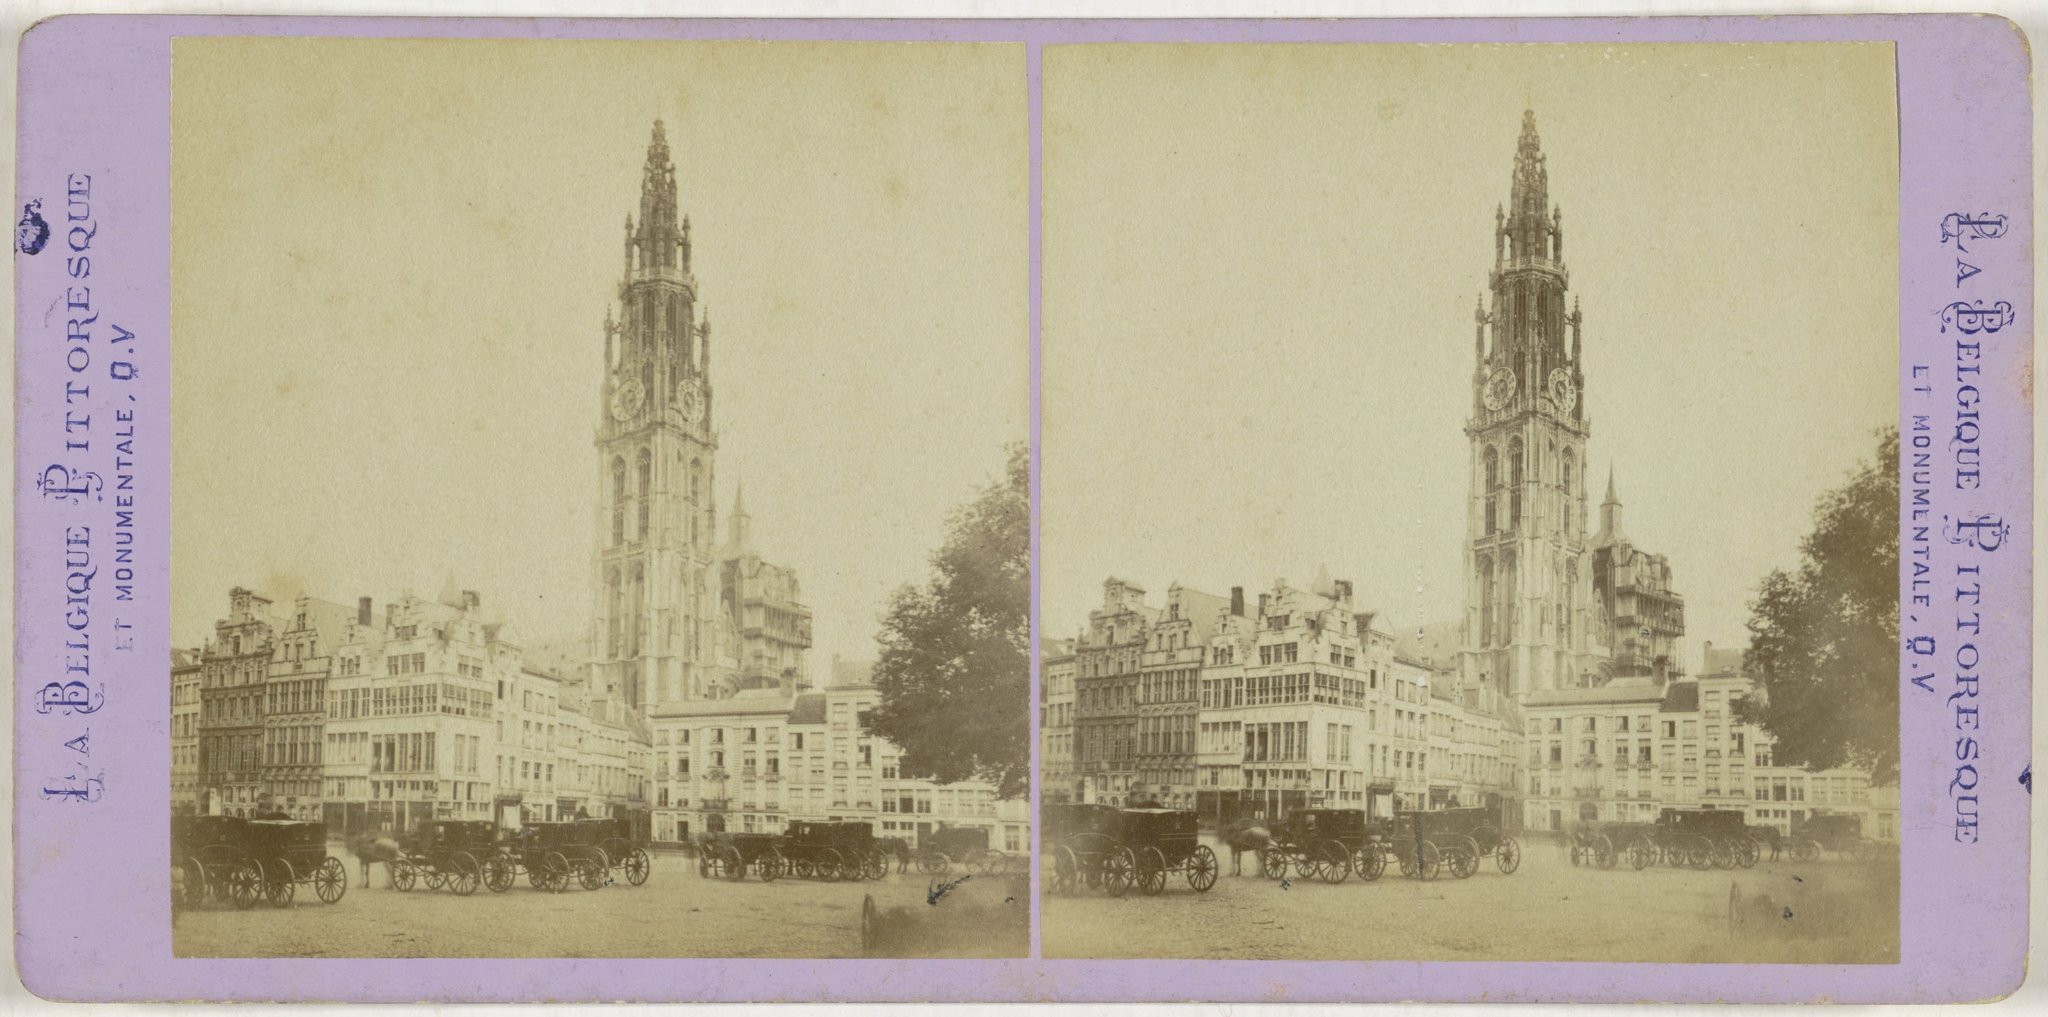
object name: stereograph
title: La Belgique pittoresque et monumentale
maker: jules hippolyte quéval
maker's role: publisher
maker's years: 1824-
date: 1866-1870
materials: cardboard, paper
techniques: albumen print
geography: antwerp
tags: square, place, circus, etc., urban housing, church (exterior)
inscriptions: number: ‘No 1645’